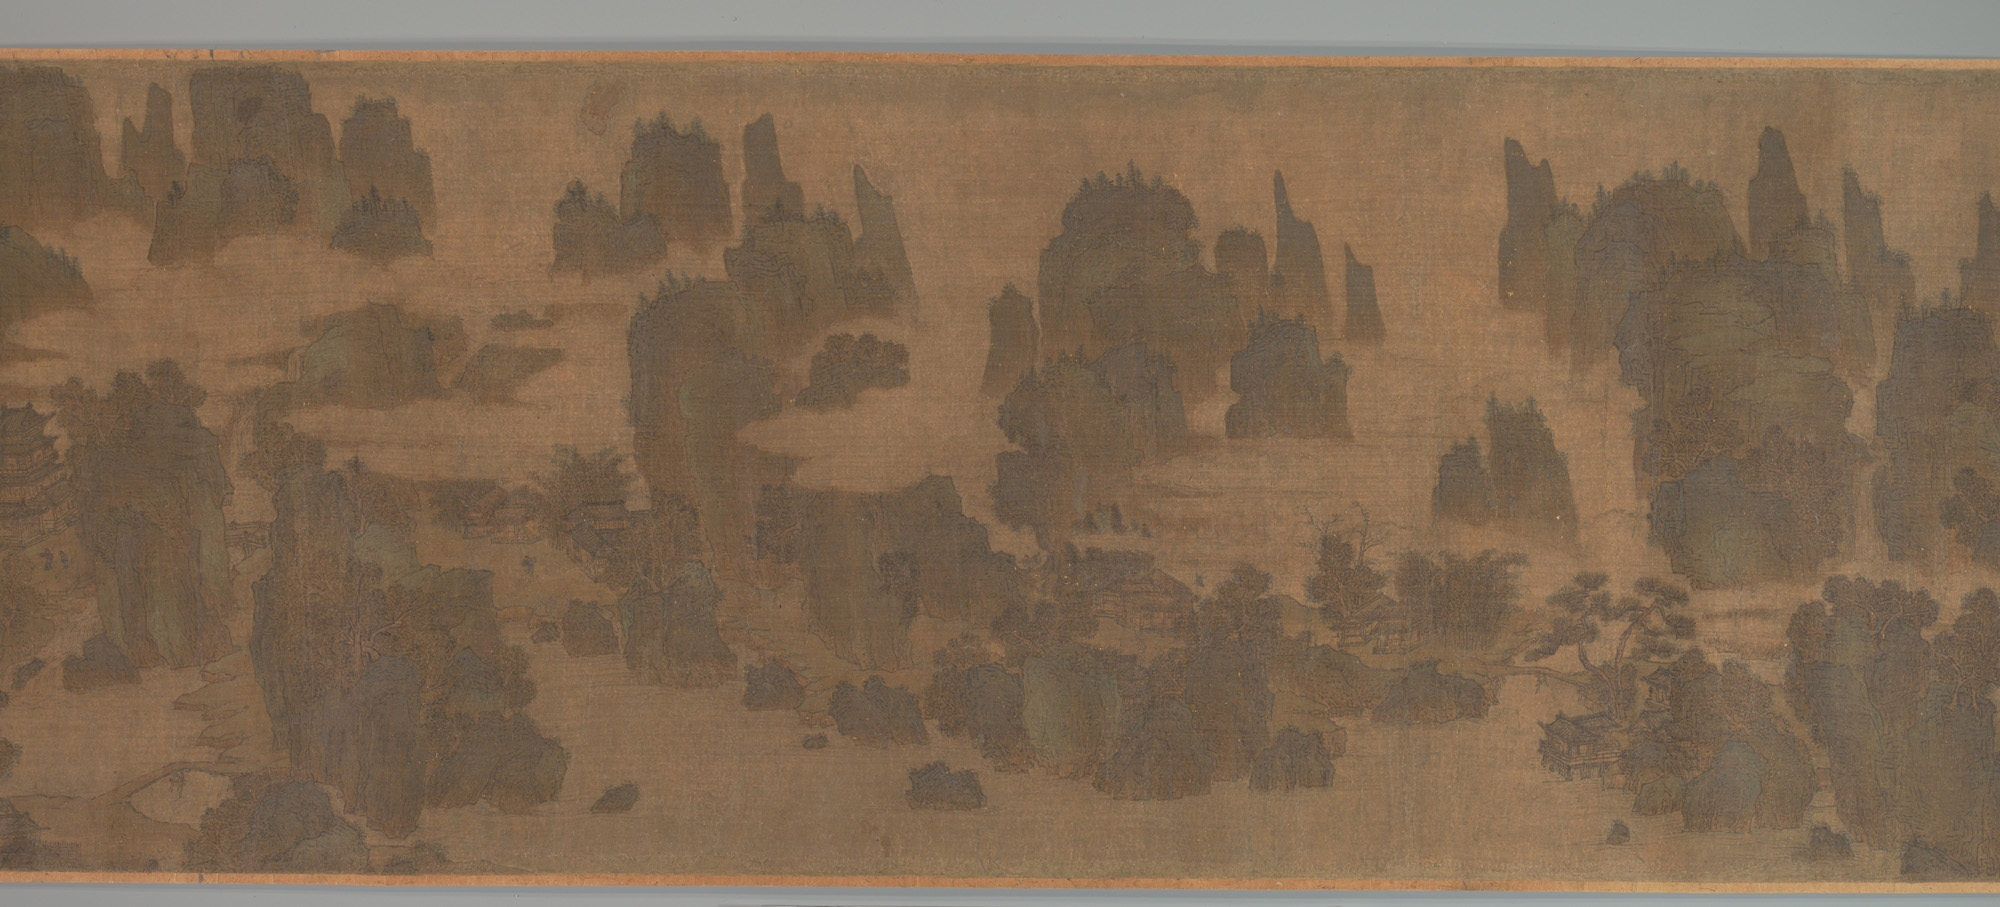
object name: handscroll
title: Retreats in the Spring Hills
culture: chinese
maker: unidentified artist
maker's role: artist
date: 1101-1150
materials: ink, silk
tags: landscapes